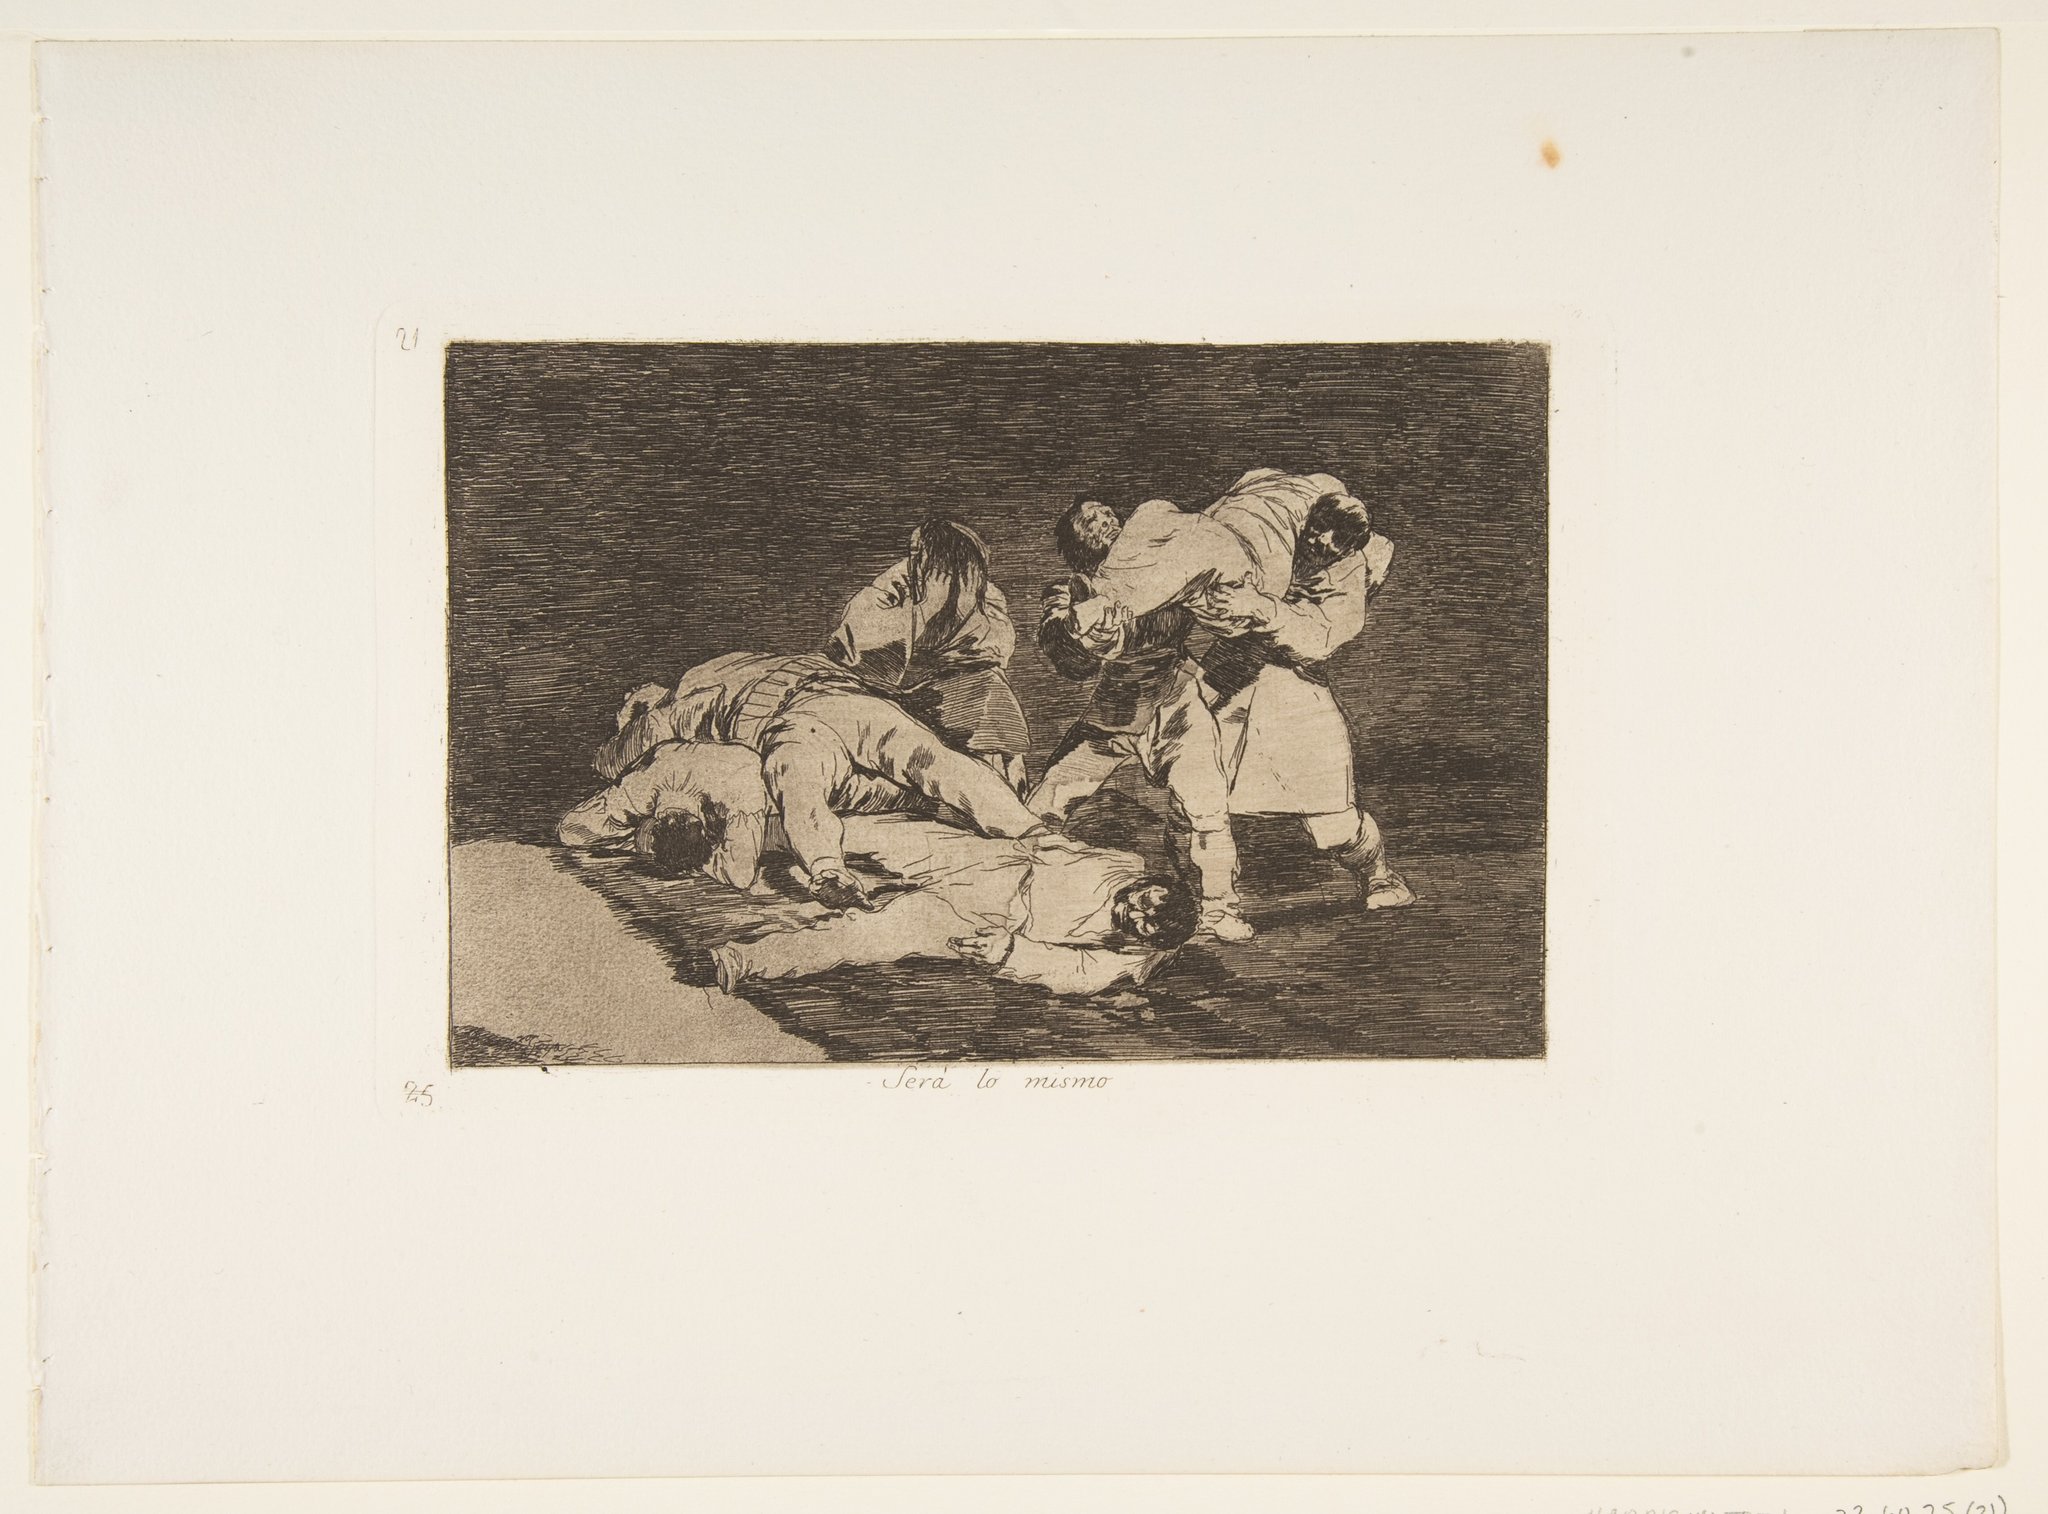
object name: print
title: Plate 21 from "The Disasters of War" (Los Desastres de la Guerra): 'It will be the same' (Será lo mismo)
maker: goya (francisco de goya y lucientes)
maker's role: artist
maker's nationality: spanish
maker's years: 1746-1828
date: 1810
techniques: burnishing, etching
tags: men,death